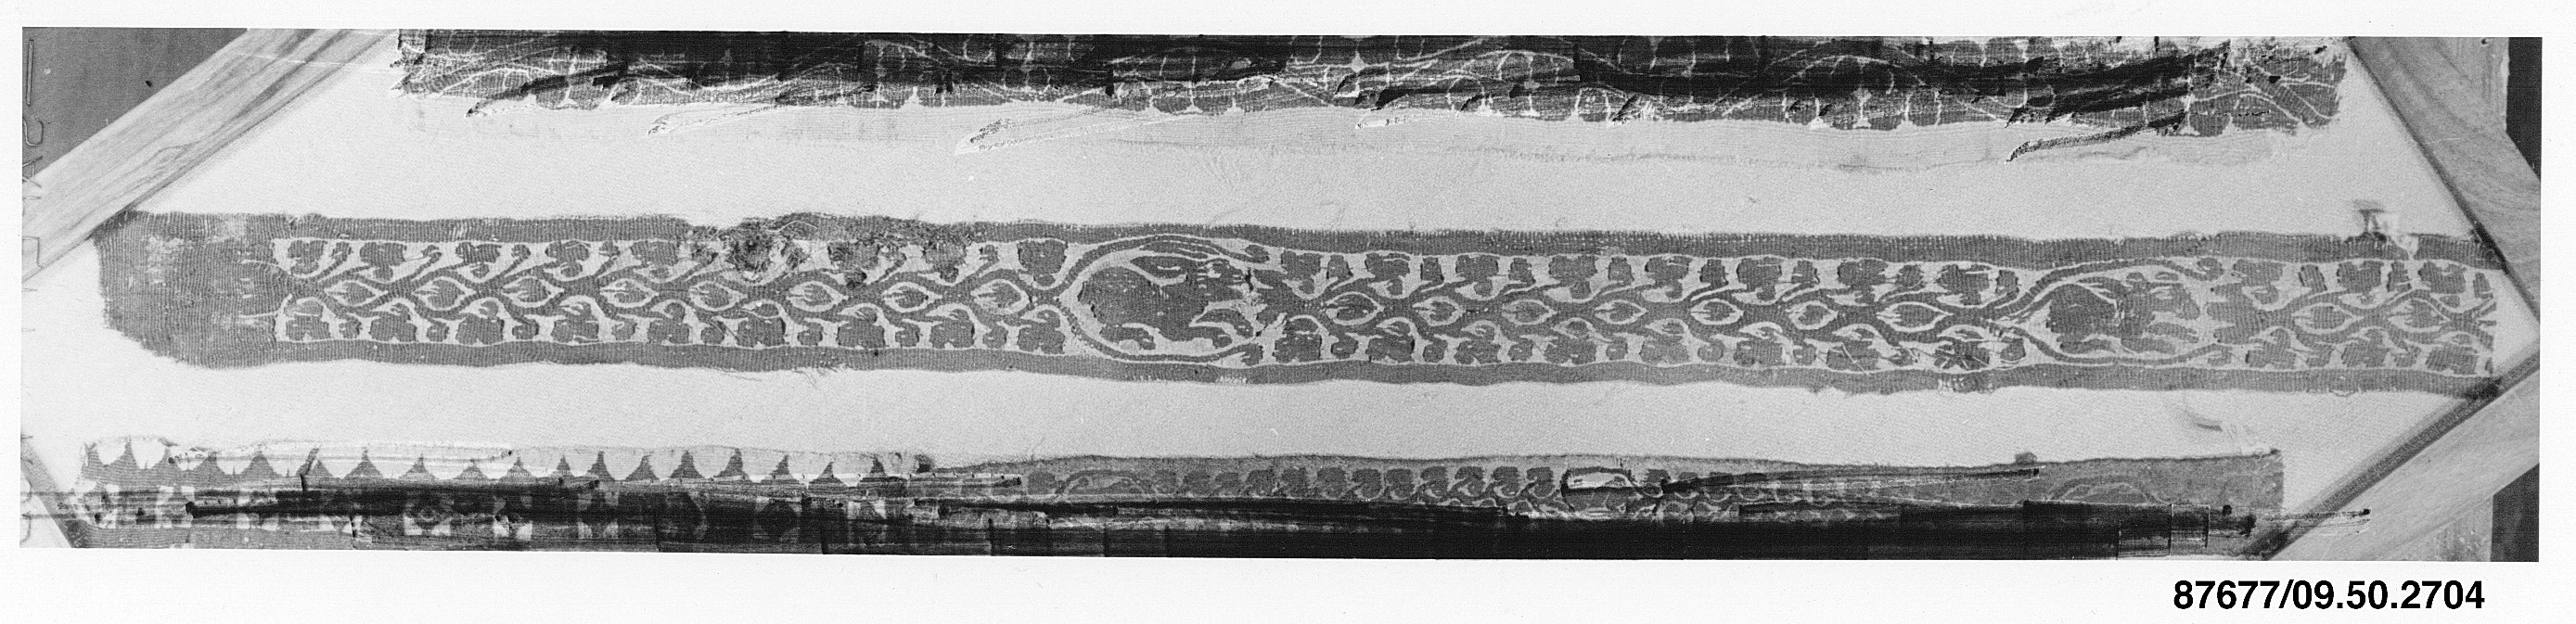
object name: band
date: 201-400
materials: linen, wool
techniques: weave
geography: egypt